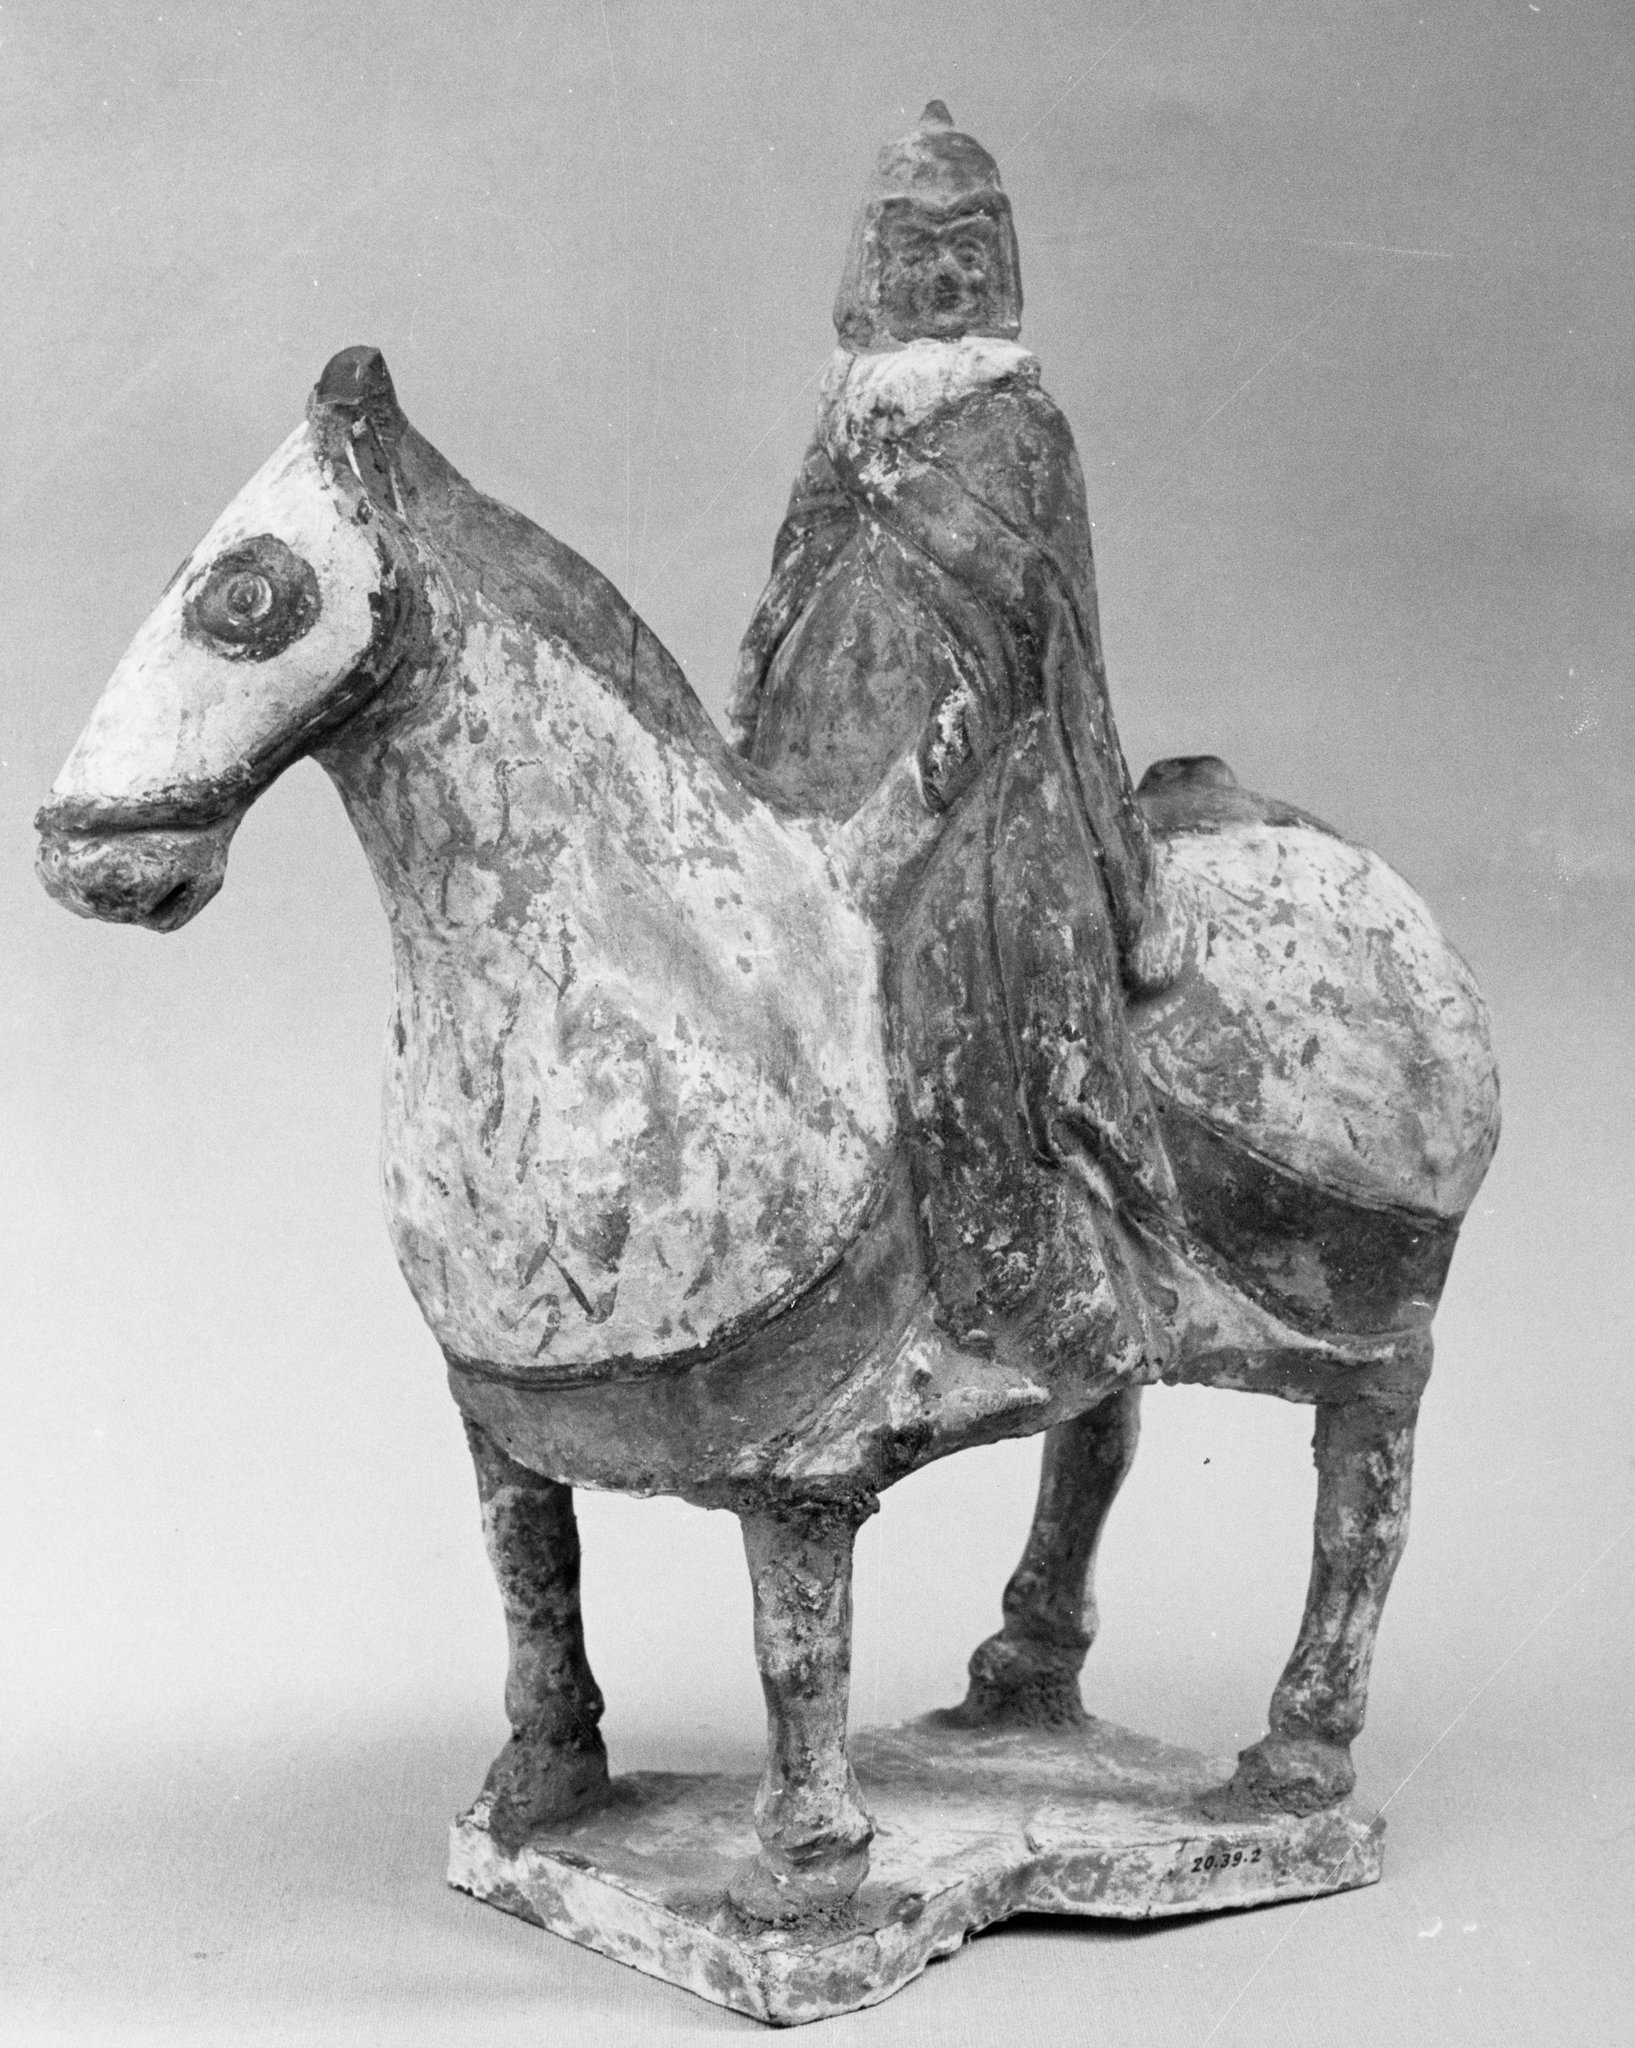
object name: figure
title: Armored horse and rider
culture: chinese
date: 501-600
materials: earthenware, pigment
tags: soldiers,men,horses